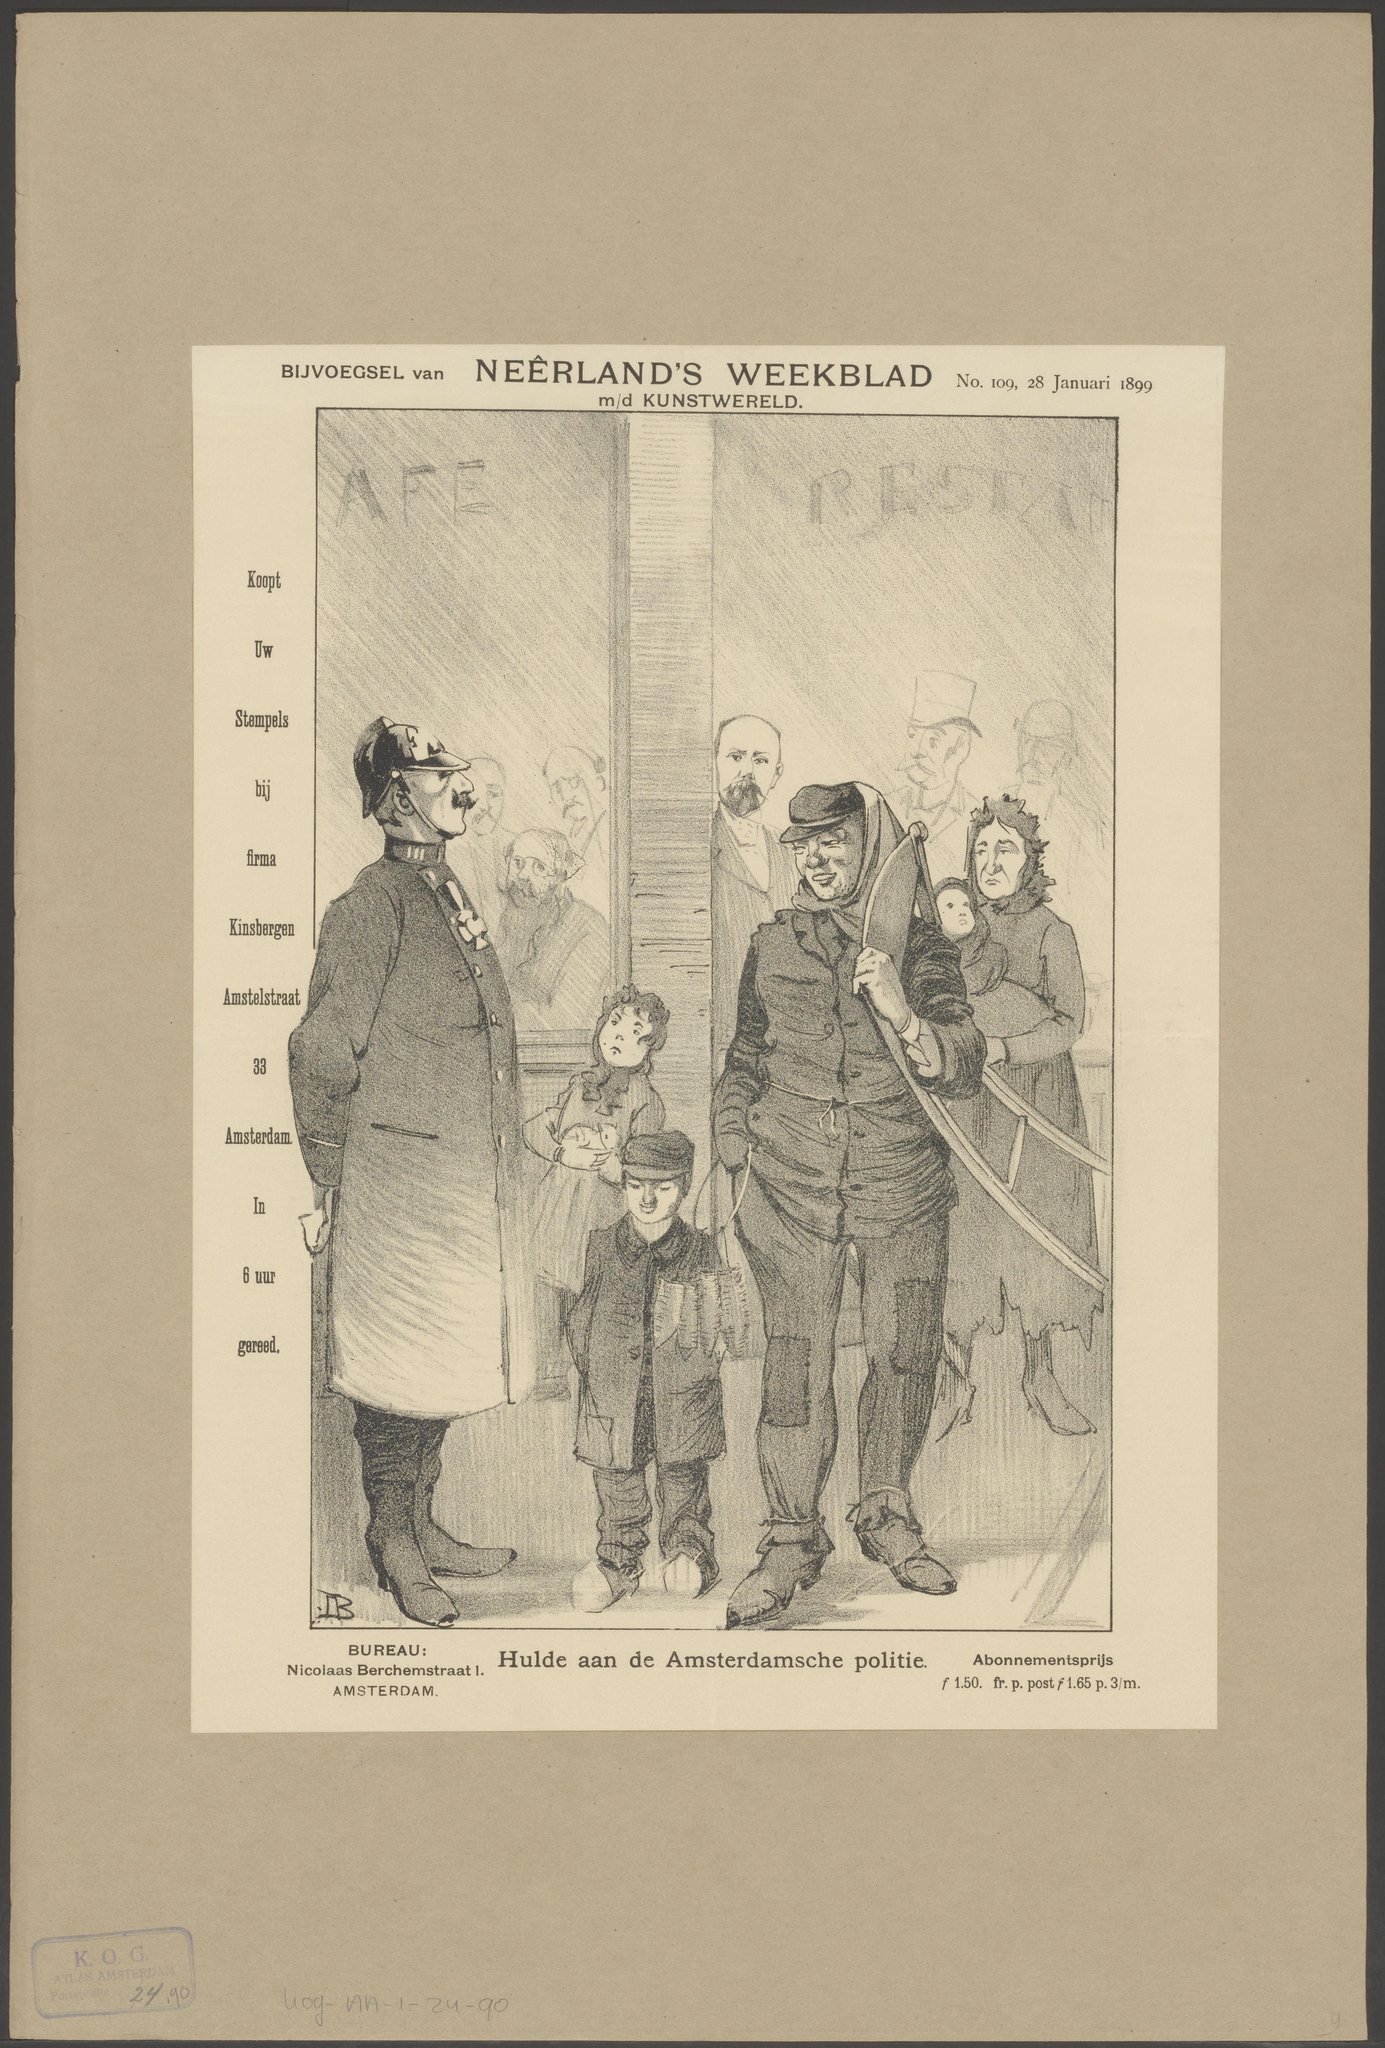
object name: print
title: Politieagent en armen voor een café-restaurant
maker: Anonymous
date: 1899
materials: paper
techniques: letterpress printing, lithograph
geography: netherlands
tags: policeman, constable, the poor, amsterdam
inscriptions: monogram: ‘AB (?)’, collector's mark: Lugt 1641b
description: Gepubliceerd als bijvoegsel van 'Neêrland's Weekblad m/d Kunstwereld', 28 januari 1899.